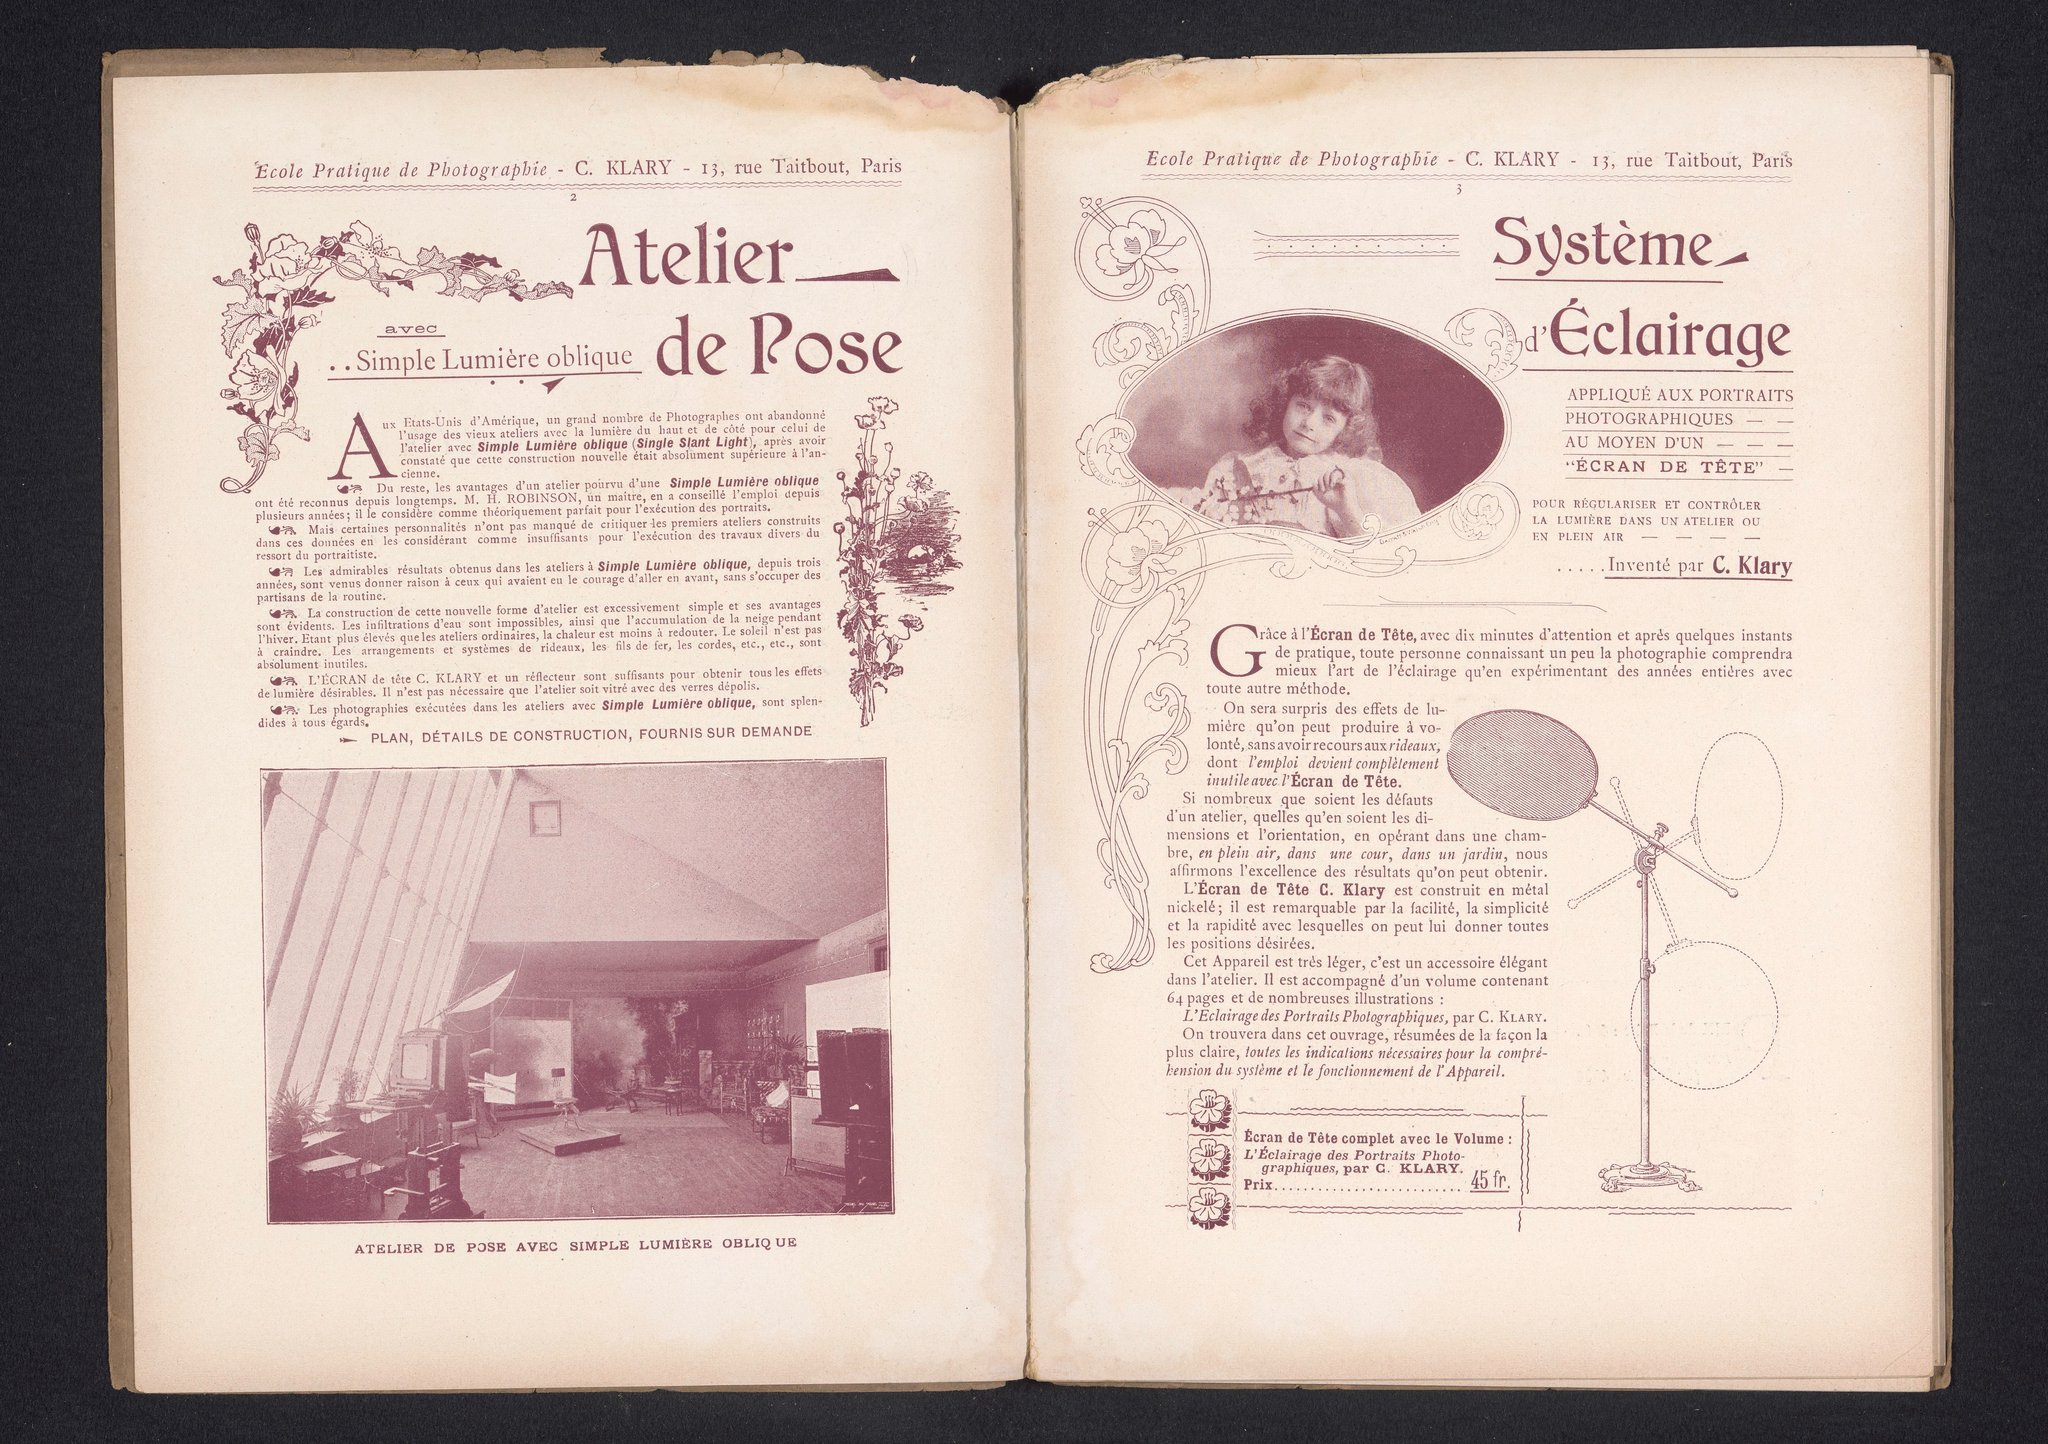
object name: page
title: Portret van een onbekend meisje met een tak met bloemen in haar hand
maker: charles louis klary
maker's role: fotograaf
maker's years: 1837-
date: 1890-1900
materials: paper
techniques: autotype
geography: paris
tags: flowers, child (at home) - aa - girl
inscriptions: name: ‘Garratt & Walsh Eng’